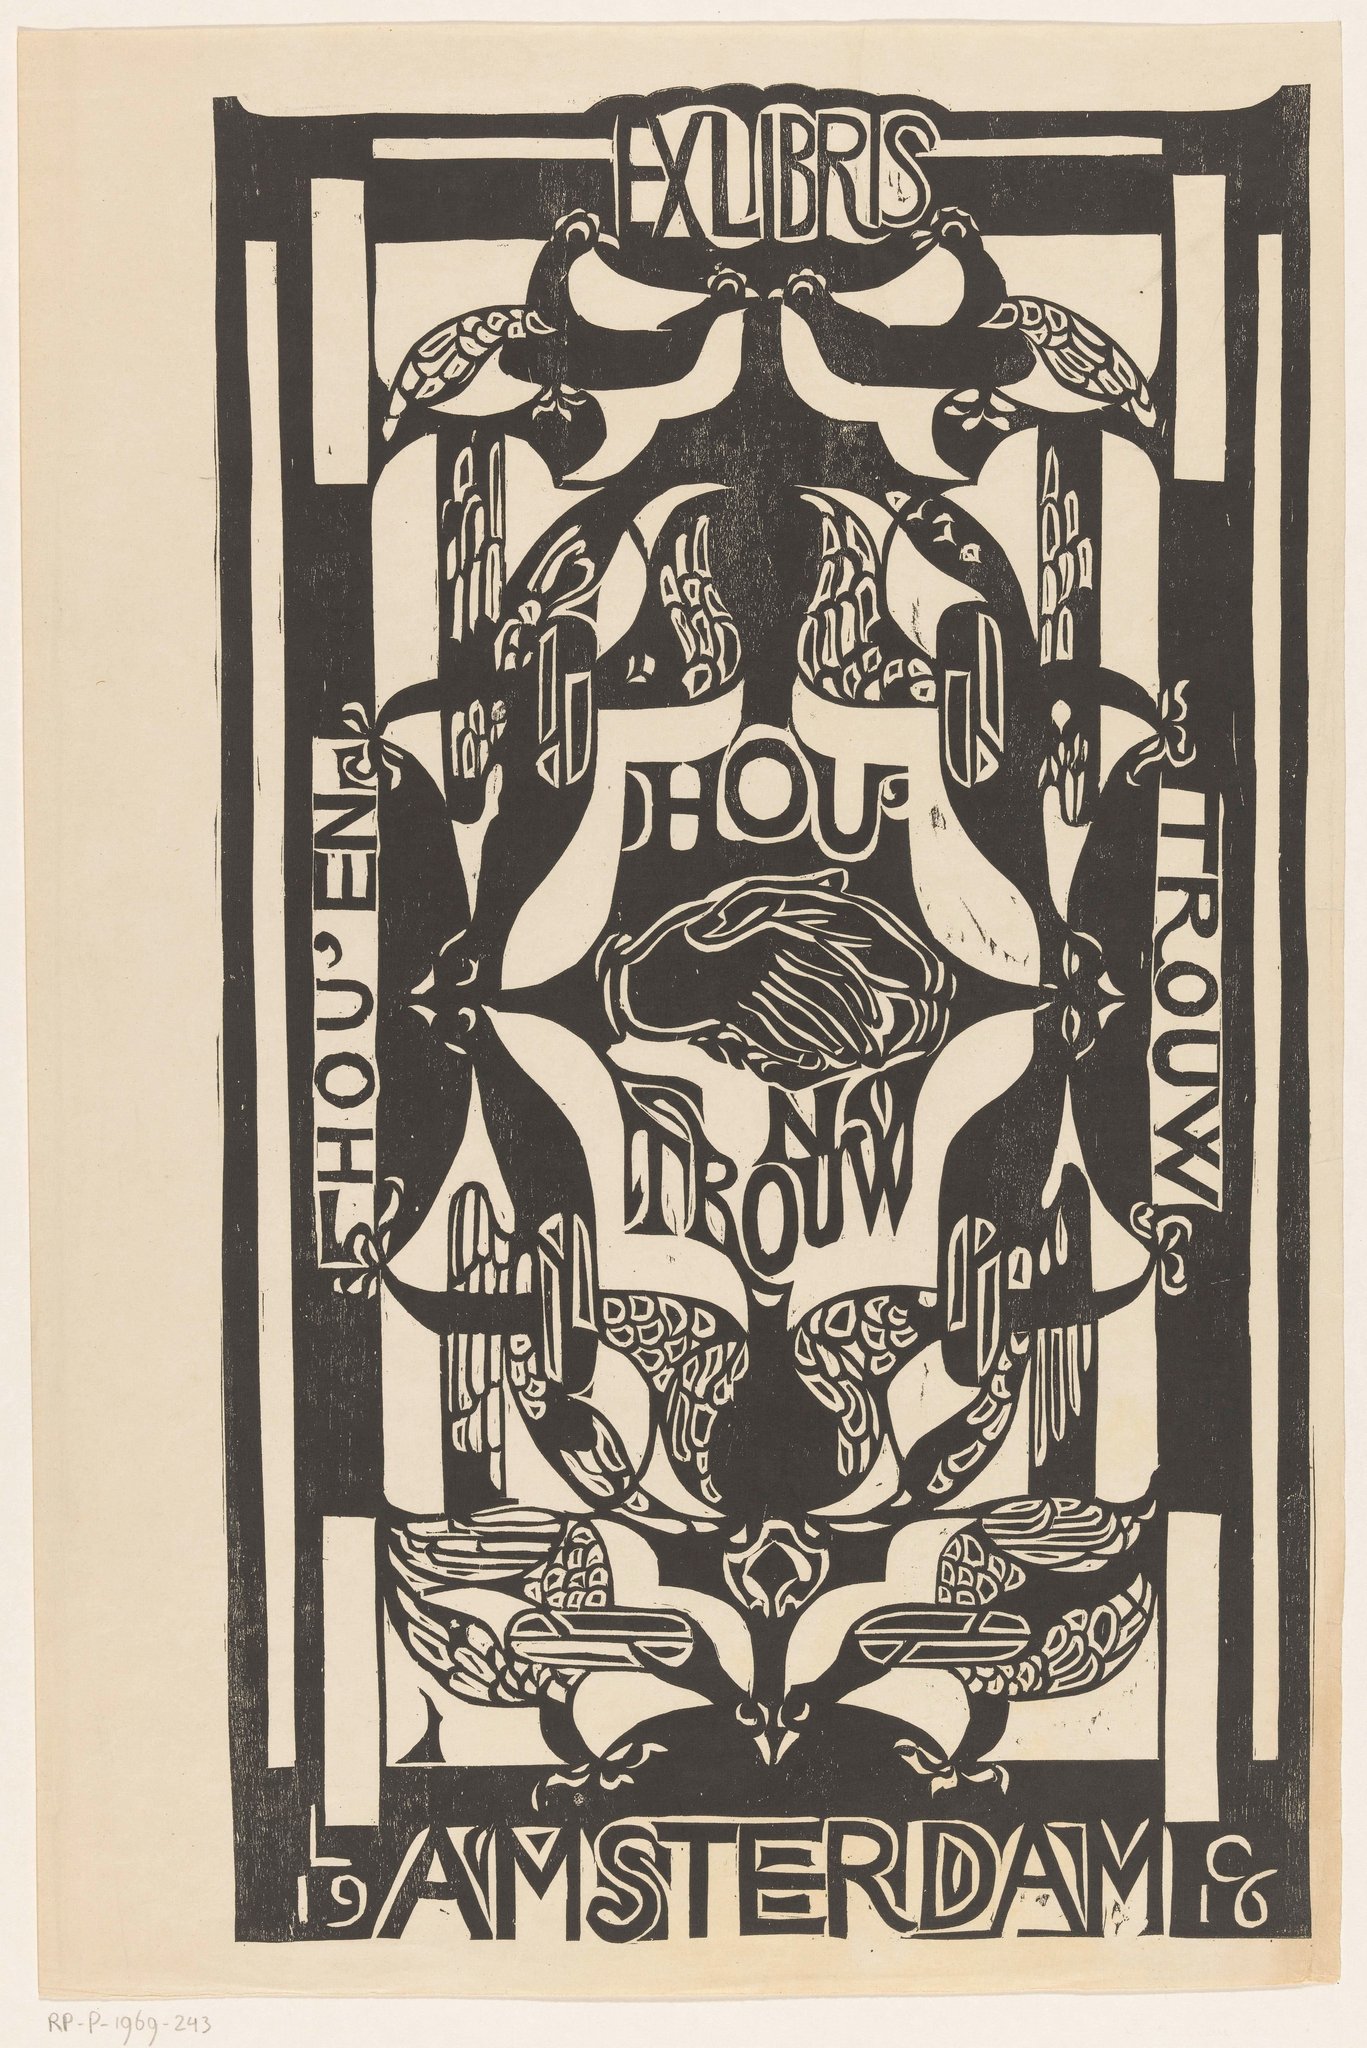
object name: bookplate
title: Ex libris van de vereniging Hou'en Trouw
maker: carel adolph lion cachet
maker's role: draughtsman, print maker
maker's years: 1864-1945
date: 1916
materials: paper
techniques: woodcut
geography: amsterdam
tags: shaking hands, 'dextrarum junctio', birds, amsterdam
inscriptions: collector's mark: Lugt 2228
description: In het midden twee handen die elkaar schudden. Links verticaal 'Hou' en', rechts verticaal 'trouw'. Boven en onder gestileerde vogels.